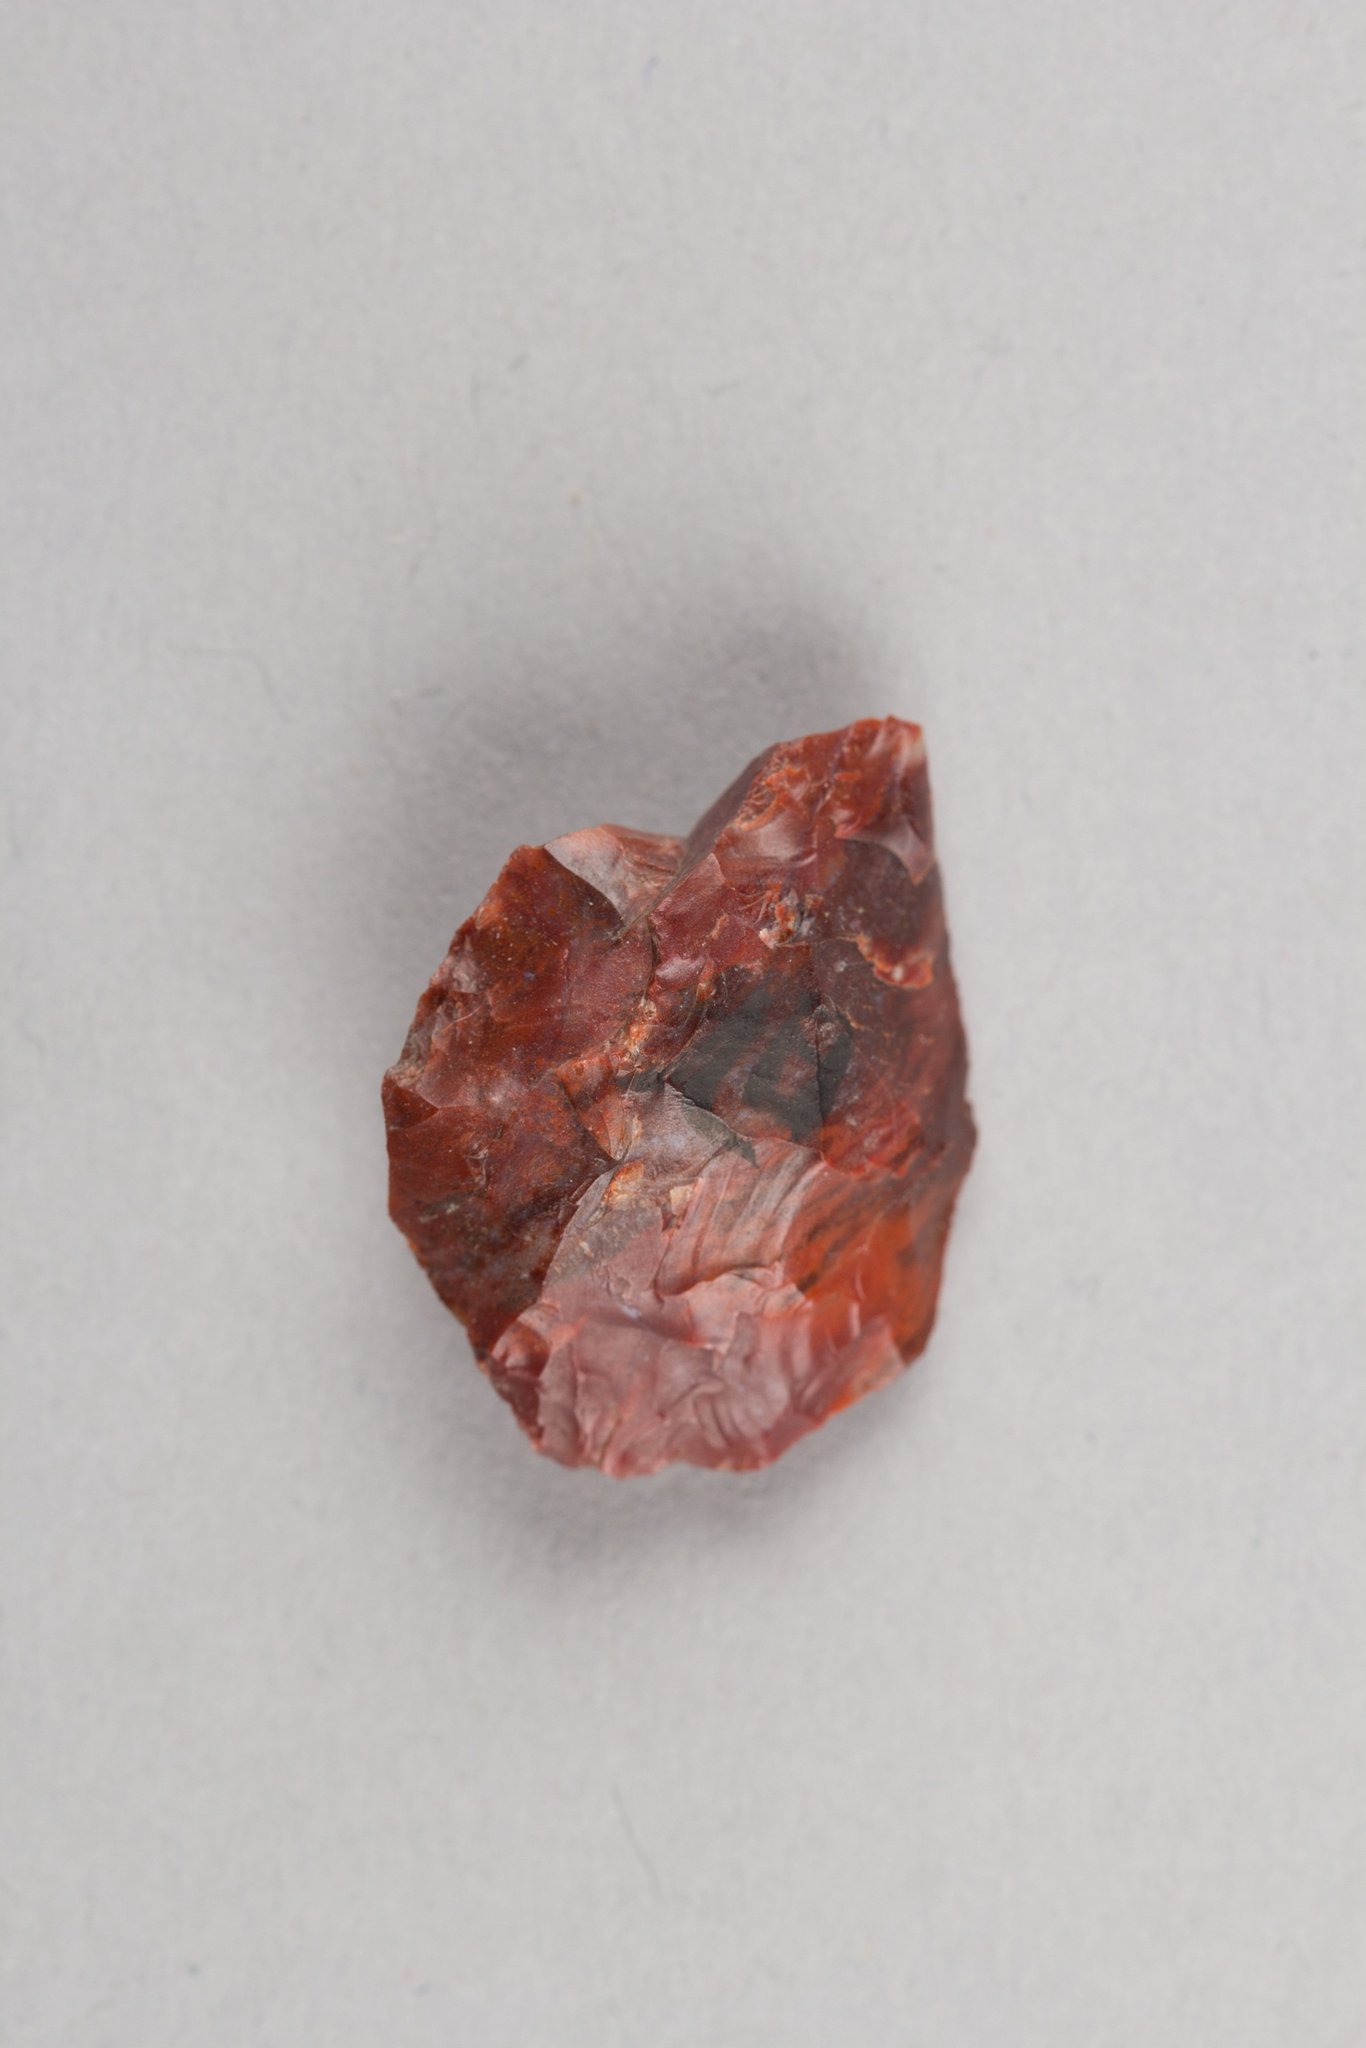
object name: arrowhead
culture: japanese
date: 1500-1000 BCE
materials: stone